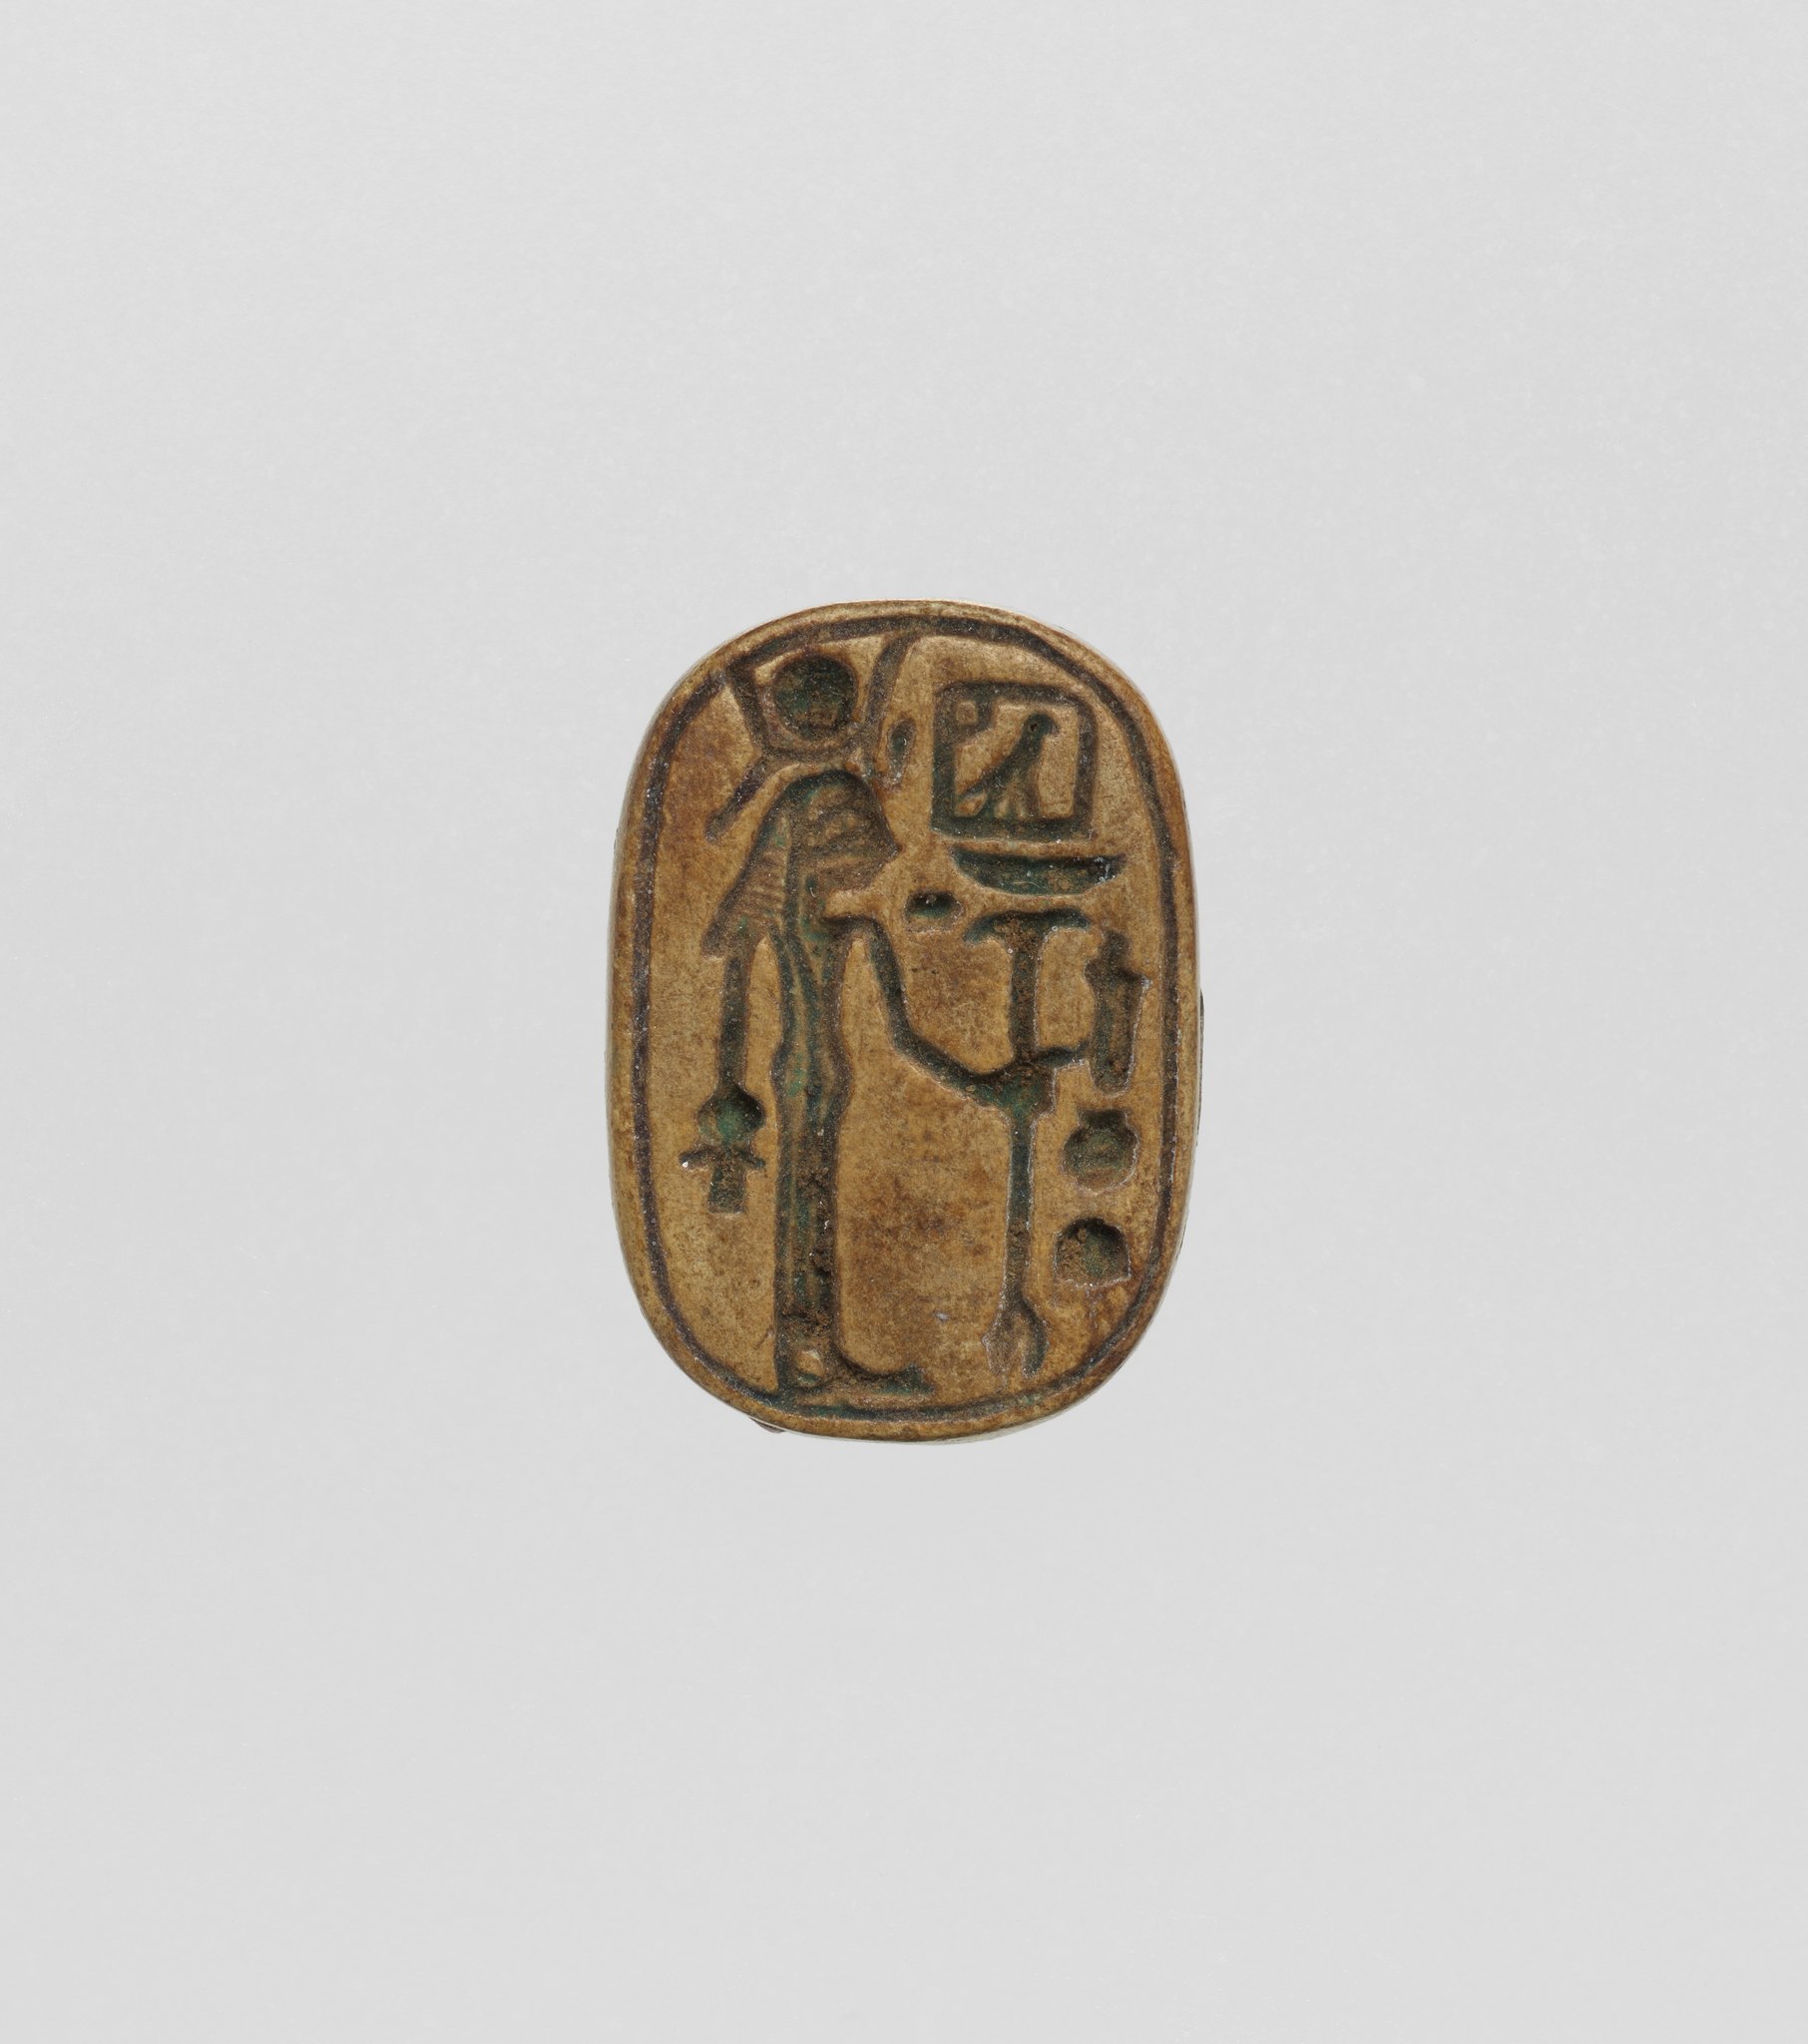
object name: amulet, plaque, oval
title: Plaque with Hathor, Mistress of Iwnw on one side, text on opposite side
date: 1295-1070 BCE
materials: stone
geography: egypt